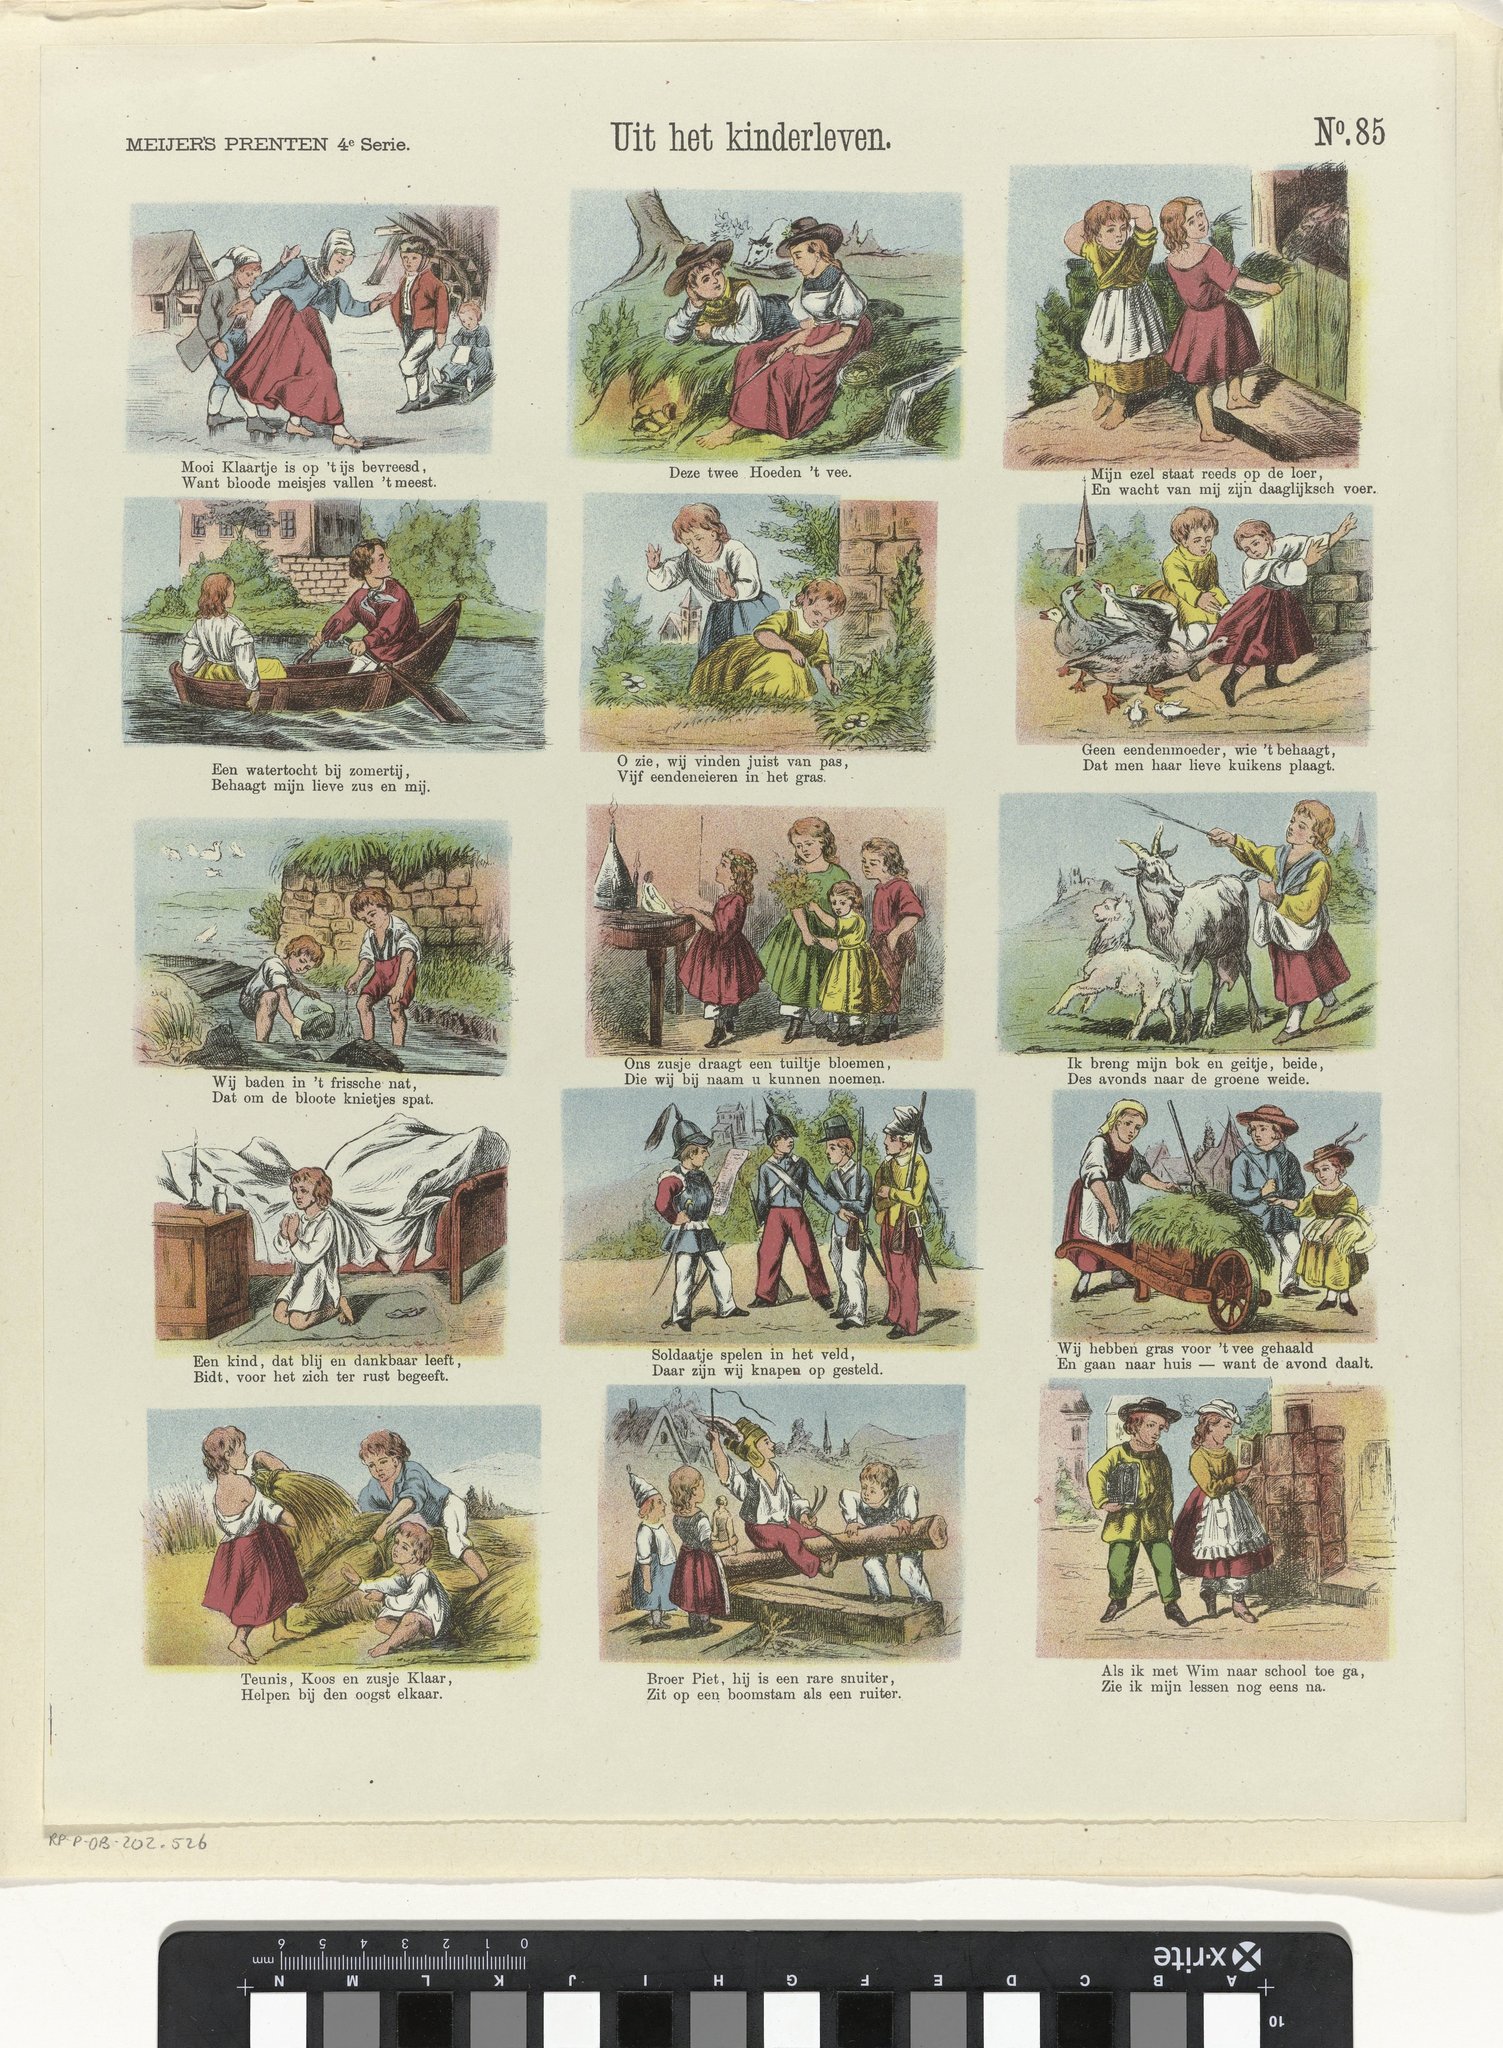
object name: print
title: Uit het kinderleven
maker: Anonymous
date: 1881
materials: paper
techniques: lithograph, letterpress printing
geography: amsterdam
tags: children's games and plays, child playing with animals, swimming (sport), rowing, canoeing, etc. (sport)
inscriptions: collector's mark: Lugt 2760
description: Blad met 15 voorstellingen van kinderspelen en bezigheden, waaronder varen, eieren zoeken, soldaatje spelen en zwemmen. Onder elke afbeelding een tweeregelig vers. Genummerd rechtsboven: No. 85.